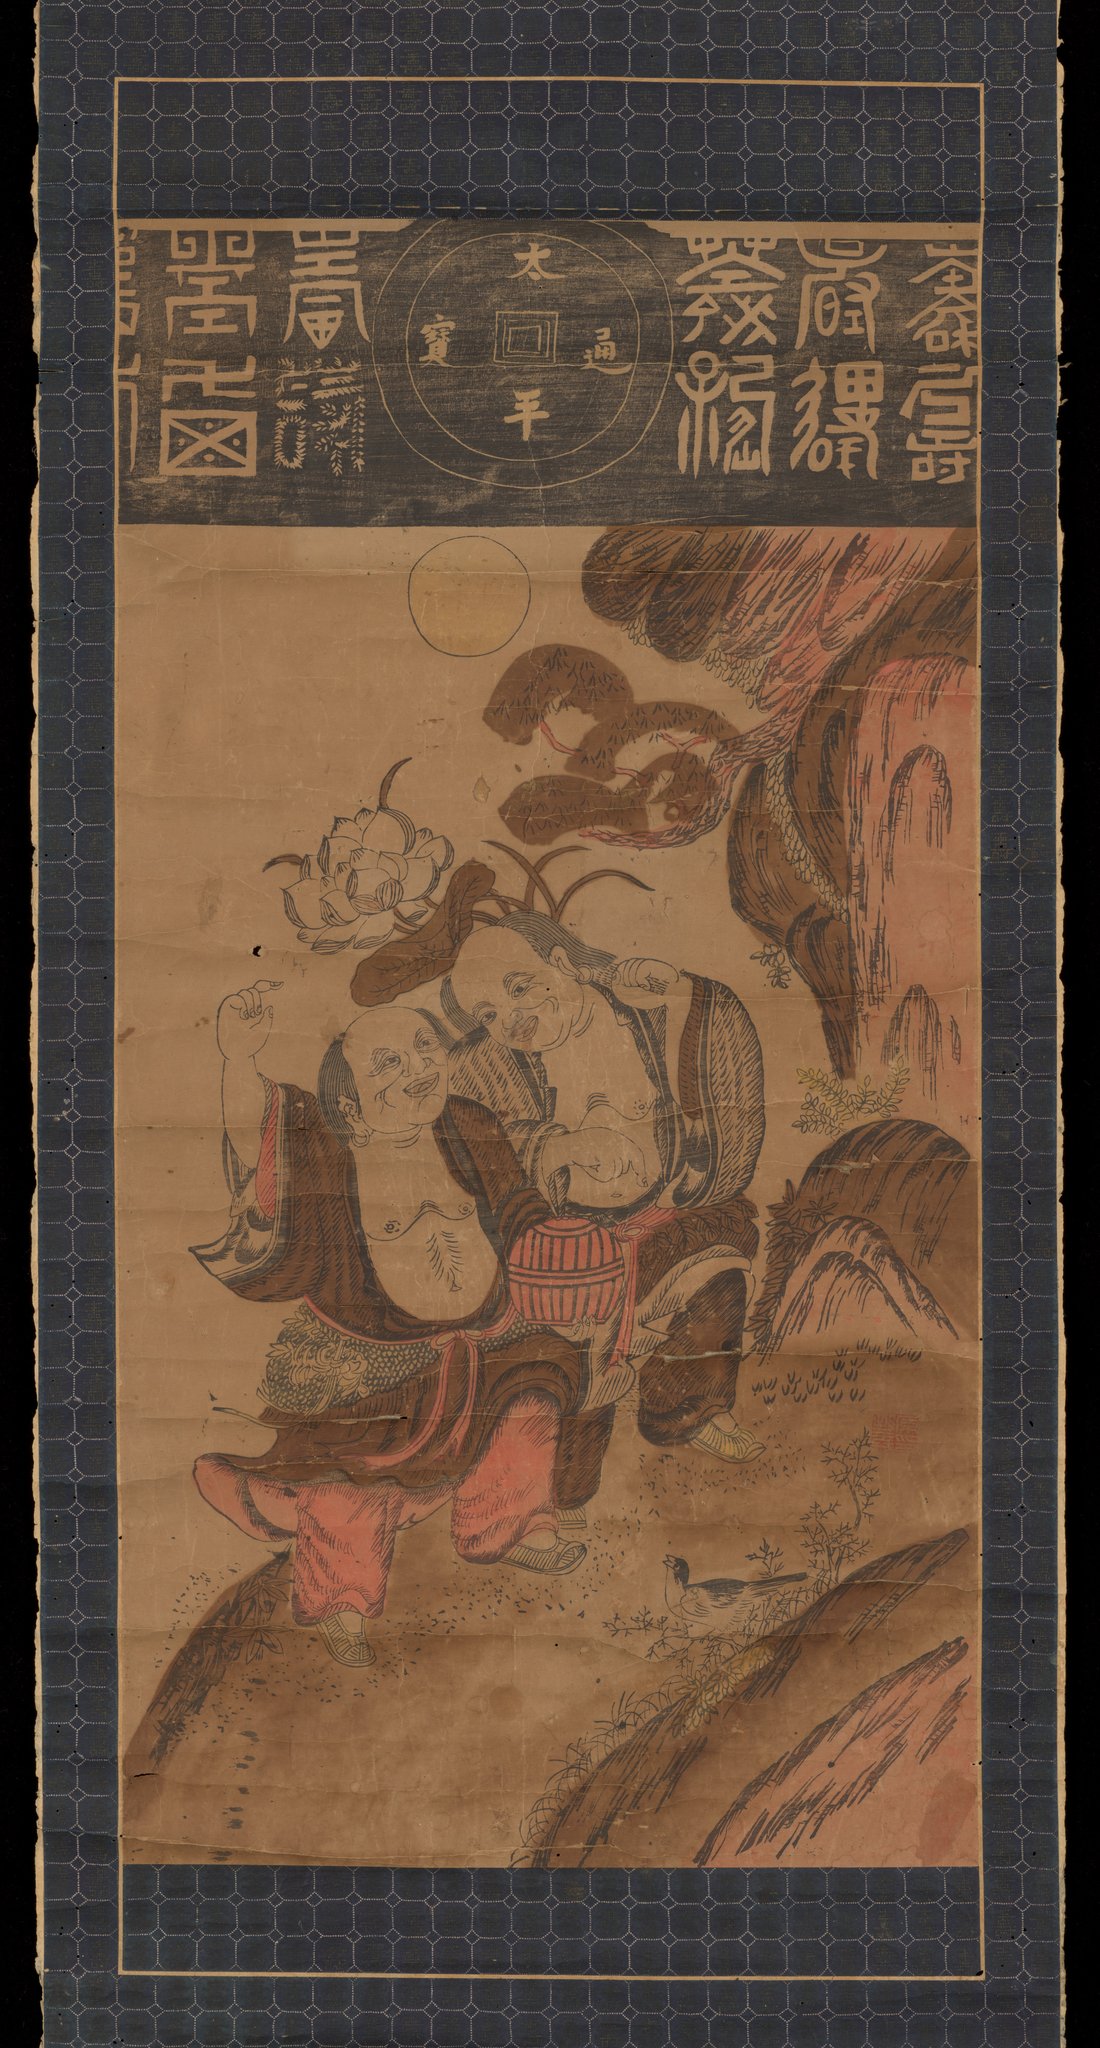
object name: print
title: The Two Immortals of Harmony and Unity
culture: chinese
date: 1736-1795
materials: ink, paper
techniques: hand coloring, woodblock print